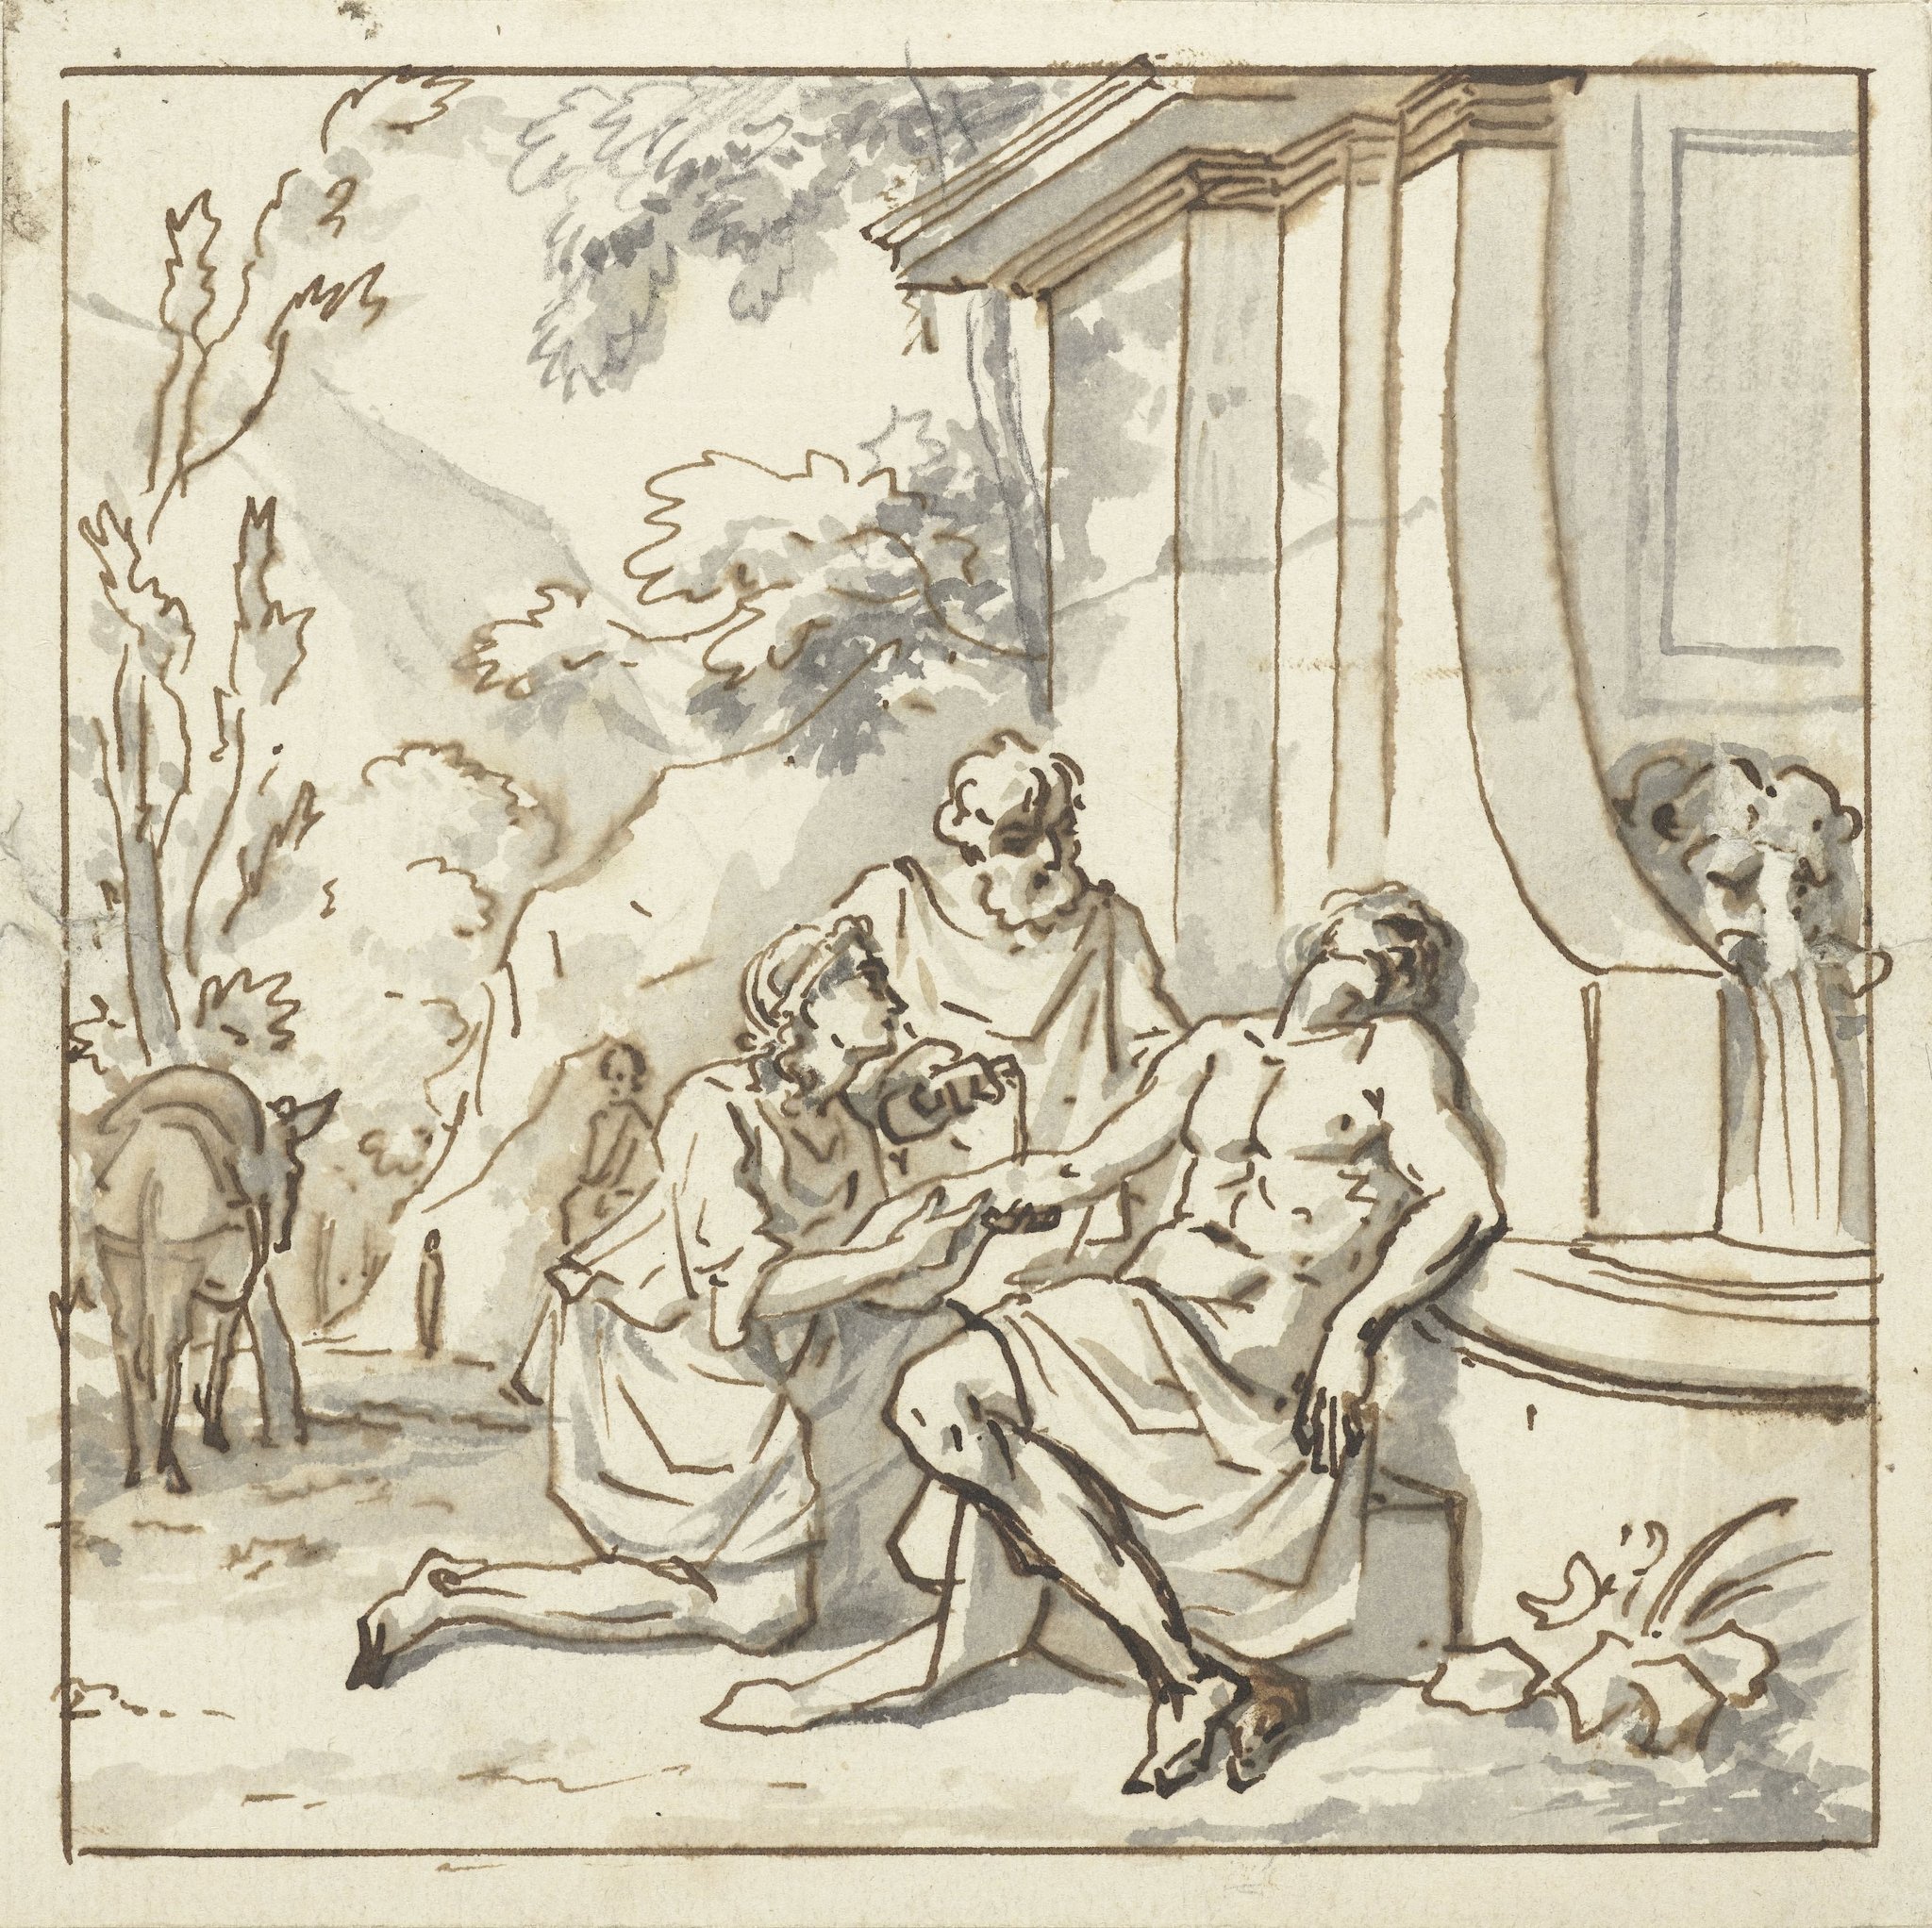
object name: drawing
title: De barmhartige Samaritaan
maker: louis fabritius dubourg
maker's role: draughtsman, print maker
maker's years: 1693-1775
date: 1703-1775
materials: ink, paper, pencil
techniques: brush, pen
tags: a samaritan tending the wounds of the traveller